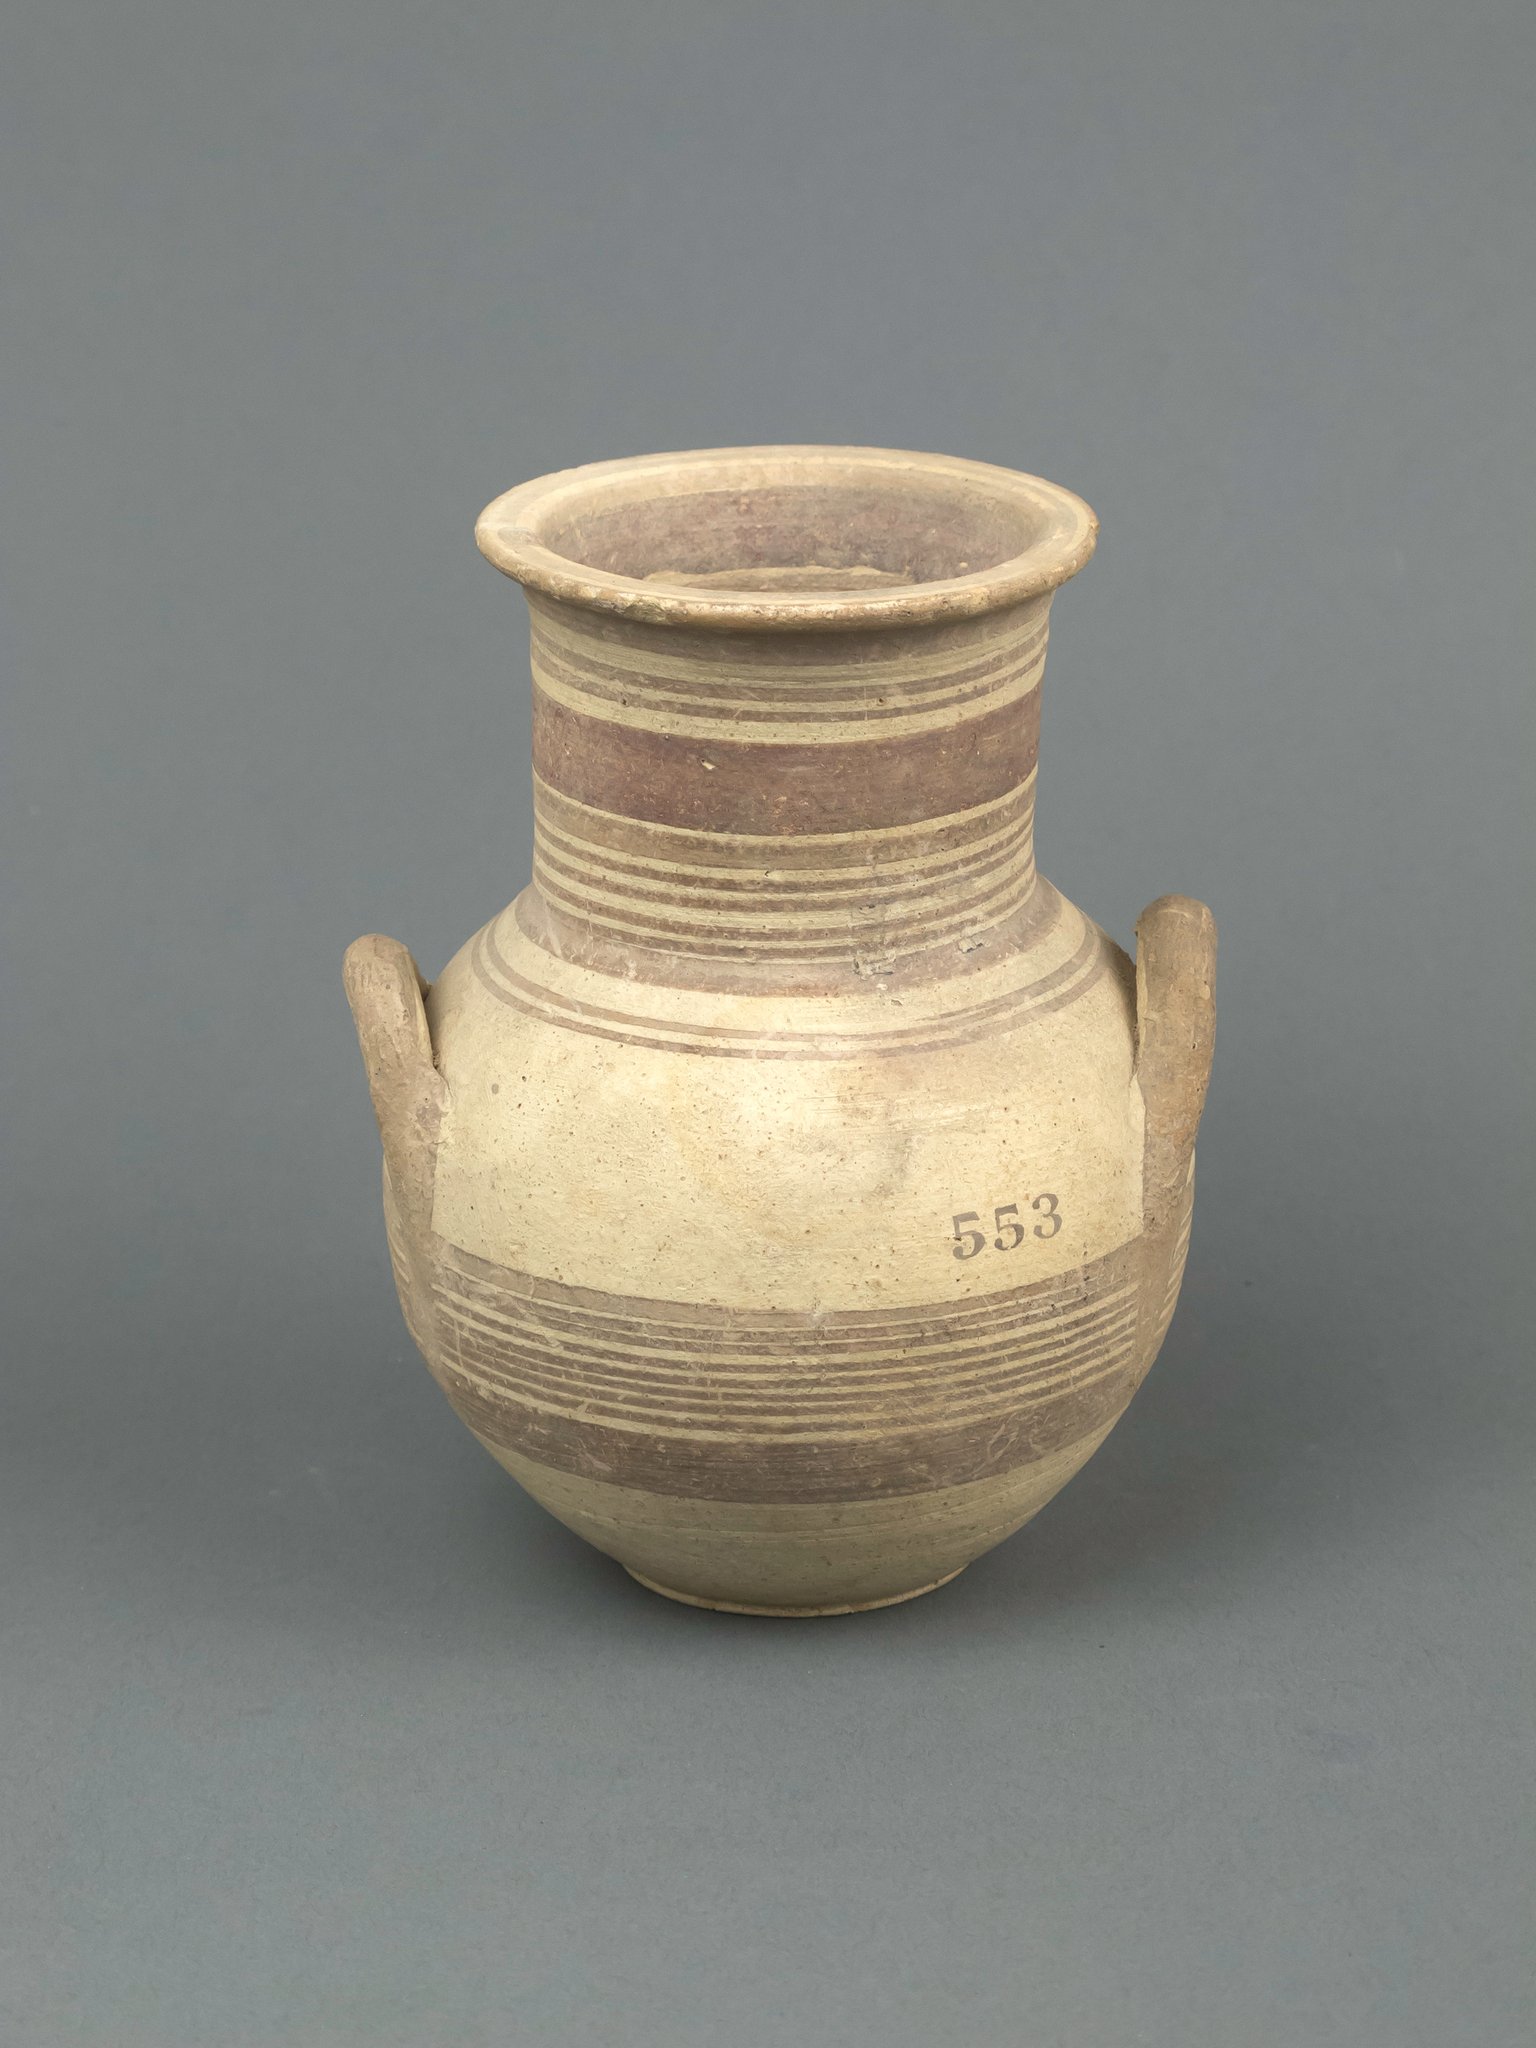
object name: amphora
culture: cypriot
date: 750-600 BCE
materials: terracotta